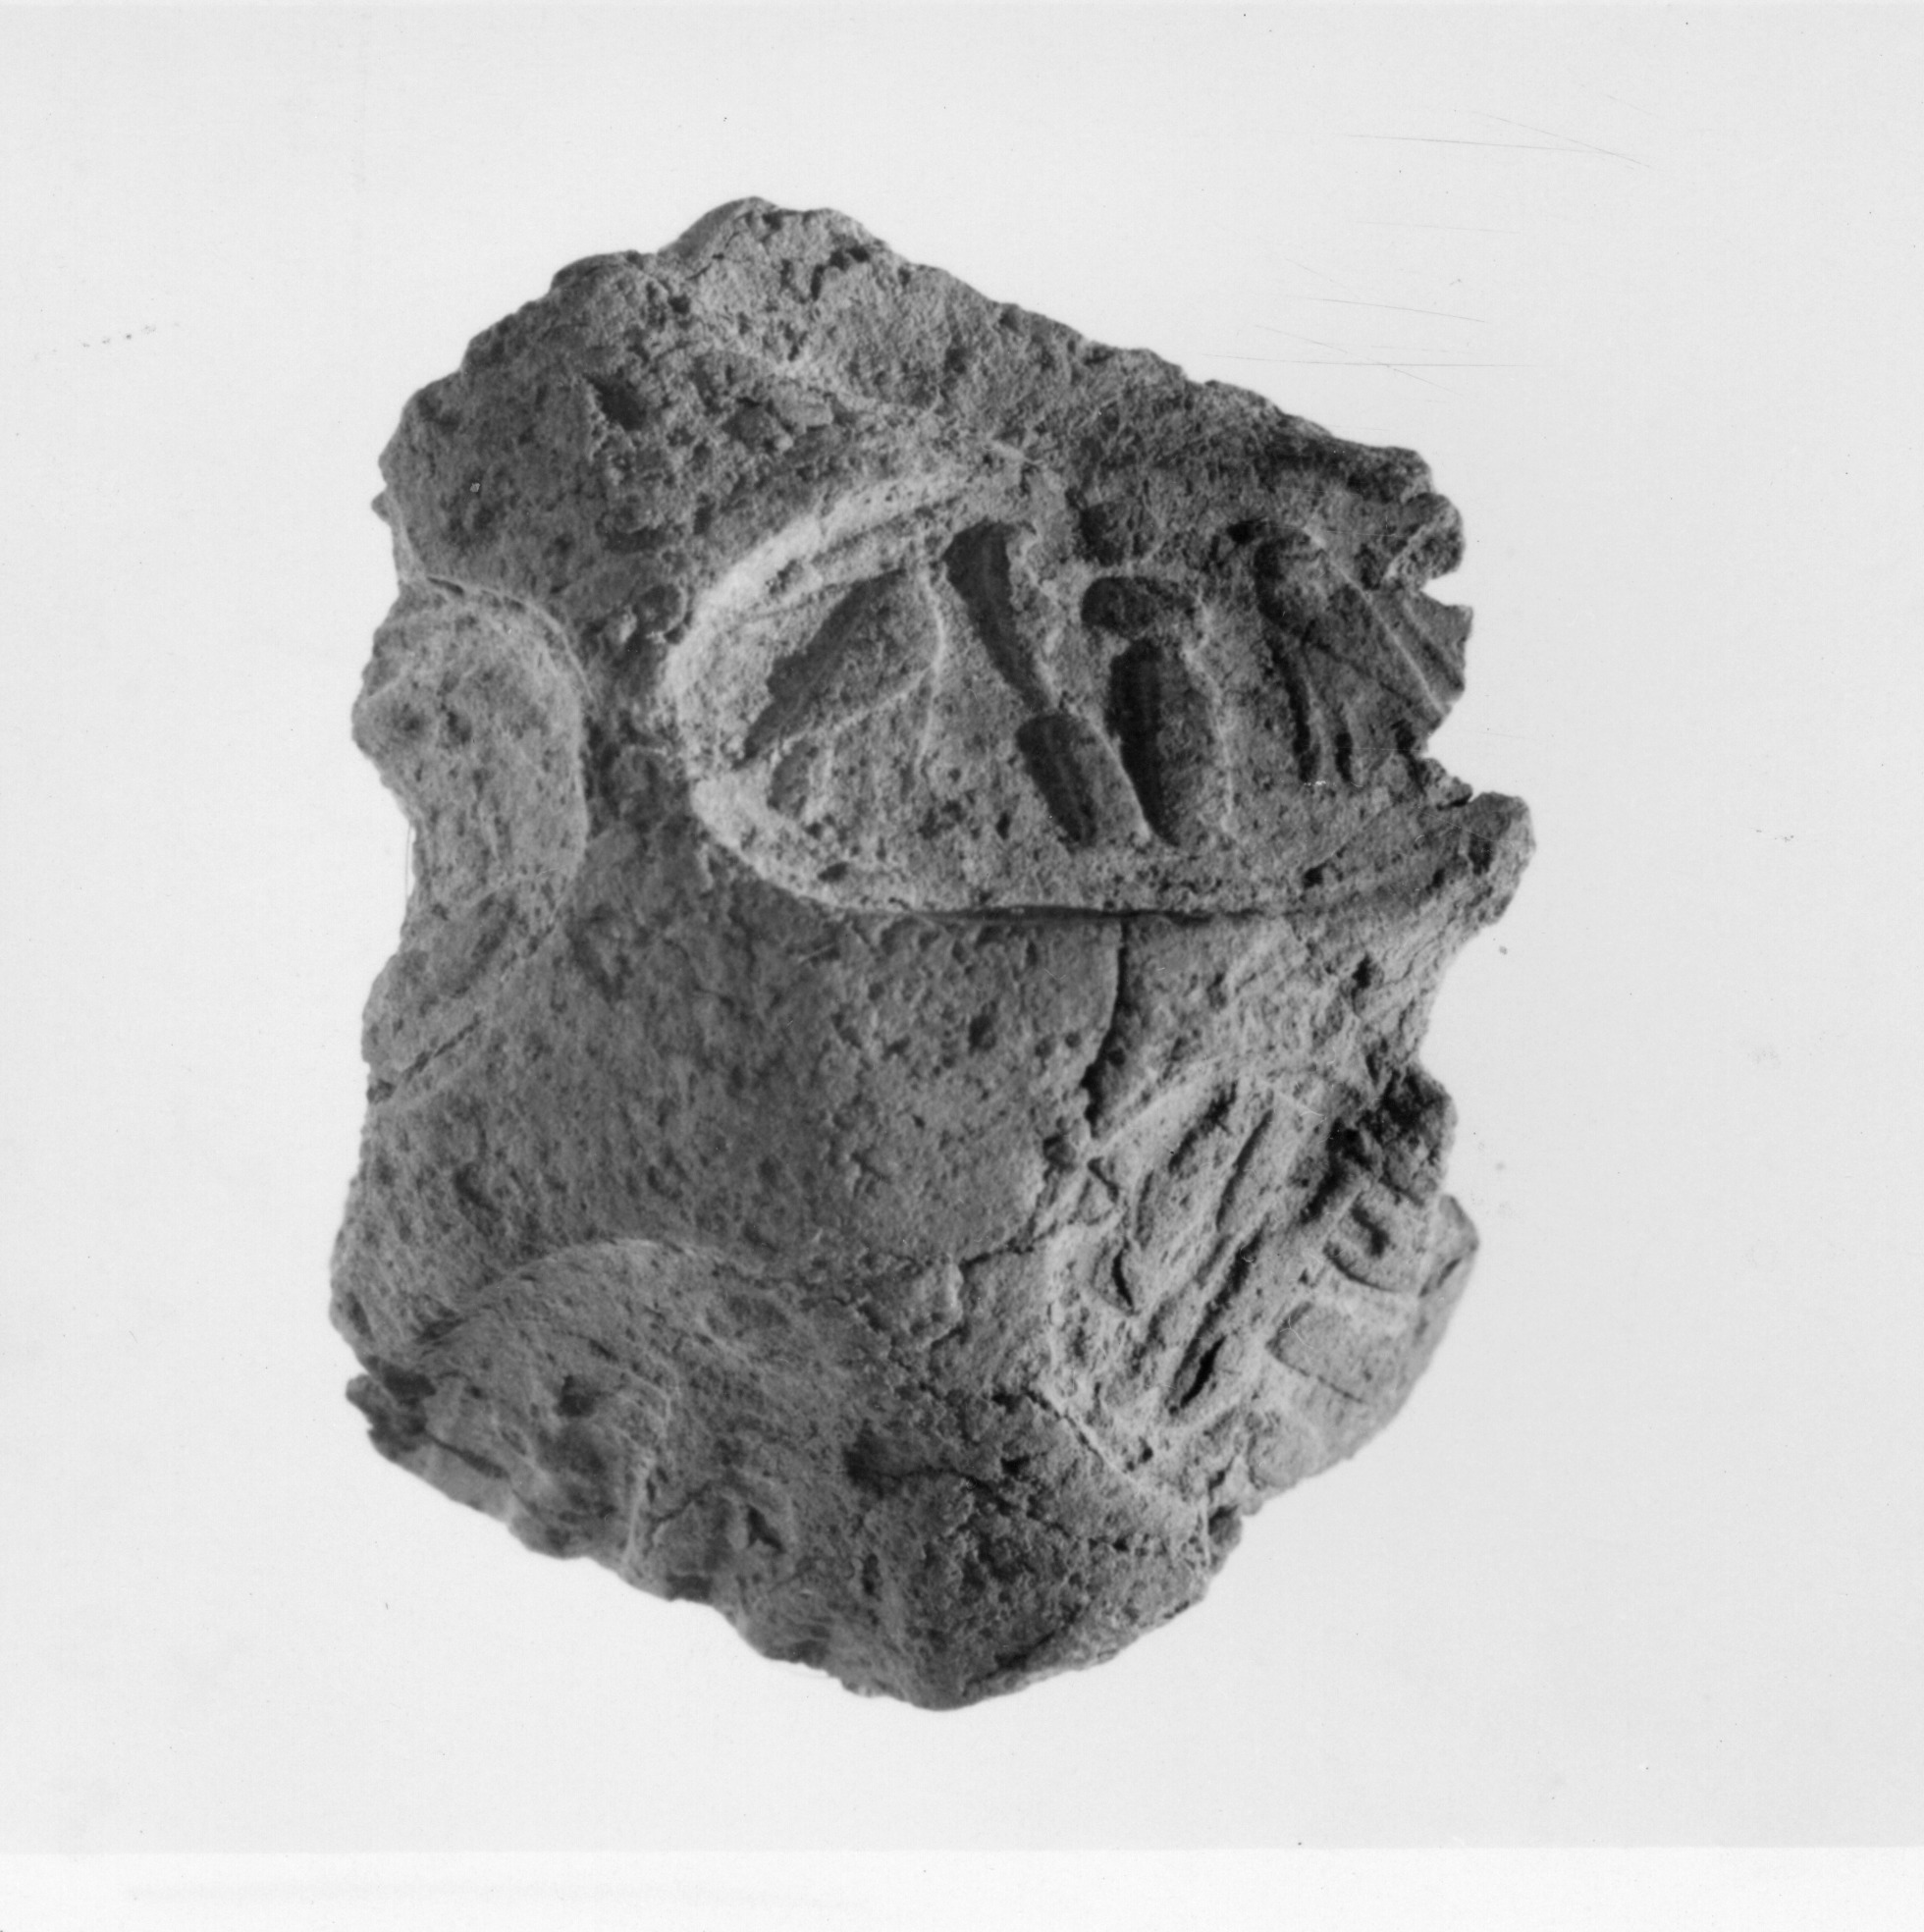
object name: sealing, not enough information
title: Document Sealing With Multiple Seal Impressions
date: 1390-1352 BCE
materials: mud